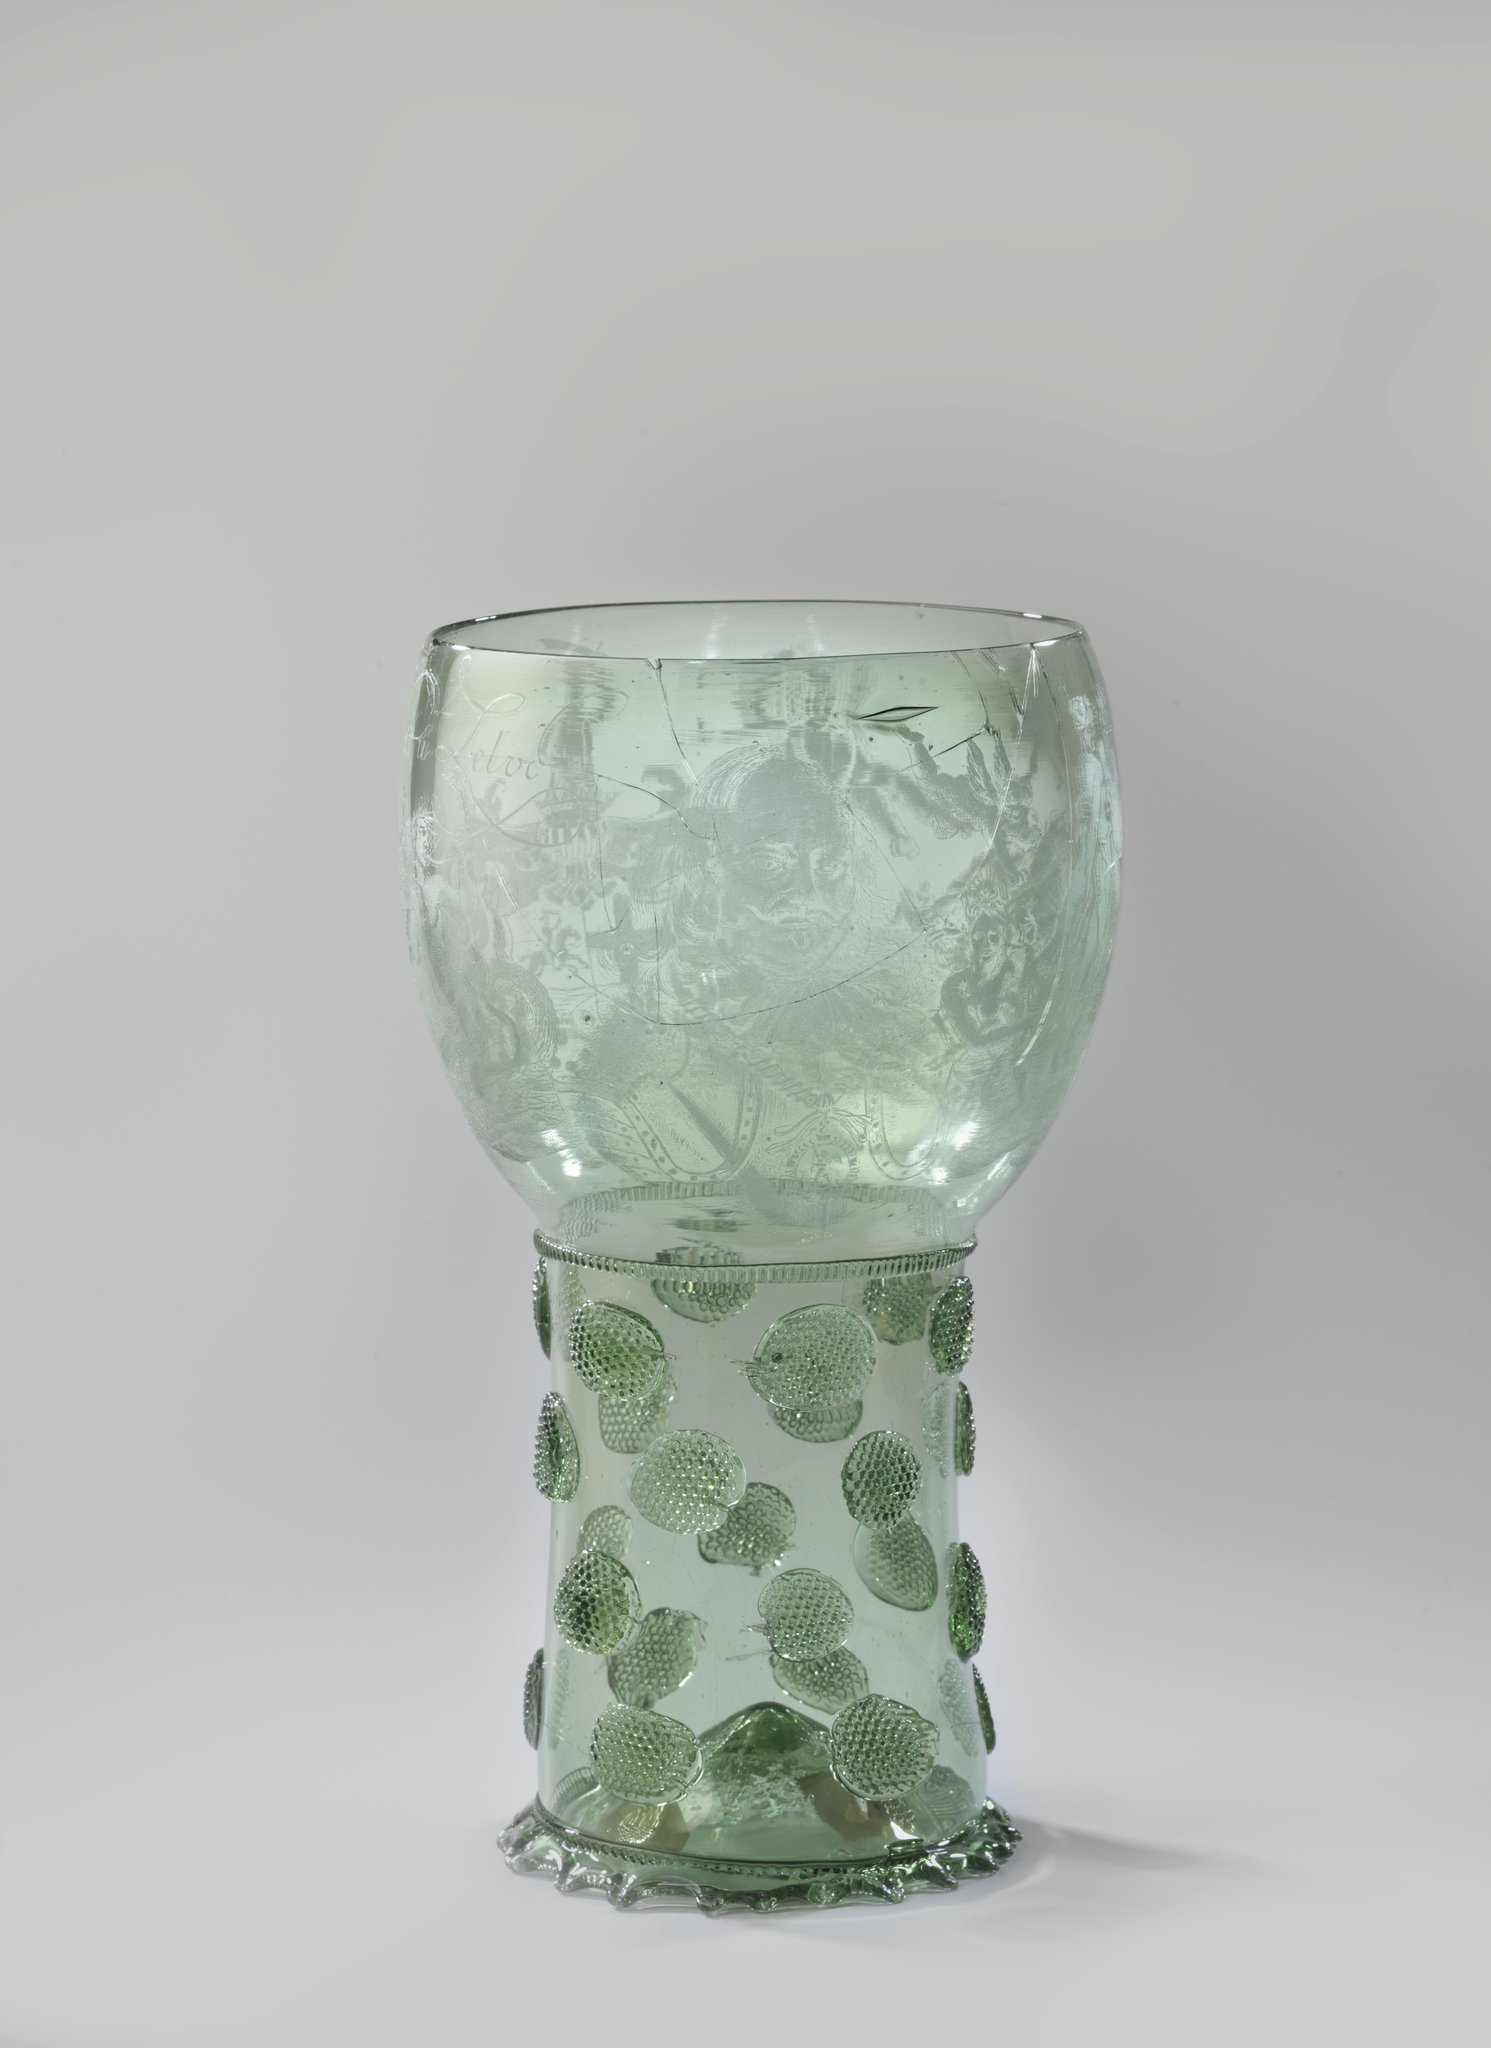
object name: roemer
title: Roemer met het wapen en een portret van Michiel Adriaenszoon de Ruyter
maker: marinus hendriksz. van gelder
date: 1671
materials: glass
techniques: diamond point engraving, glassblowing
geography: rotterdam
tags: flushing, michiel adriaenszoon de ruyter, historical persons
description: Rummer with arms and portrait of De Ruyter, engraved by Marinus van Gelder, Rotterdam, 1671.